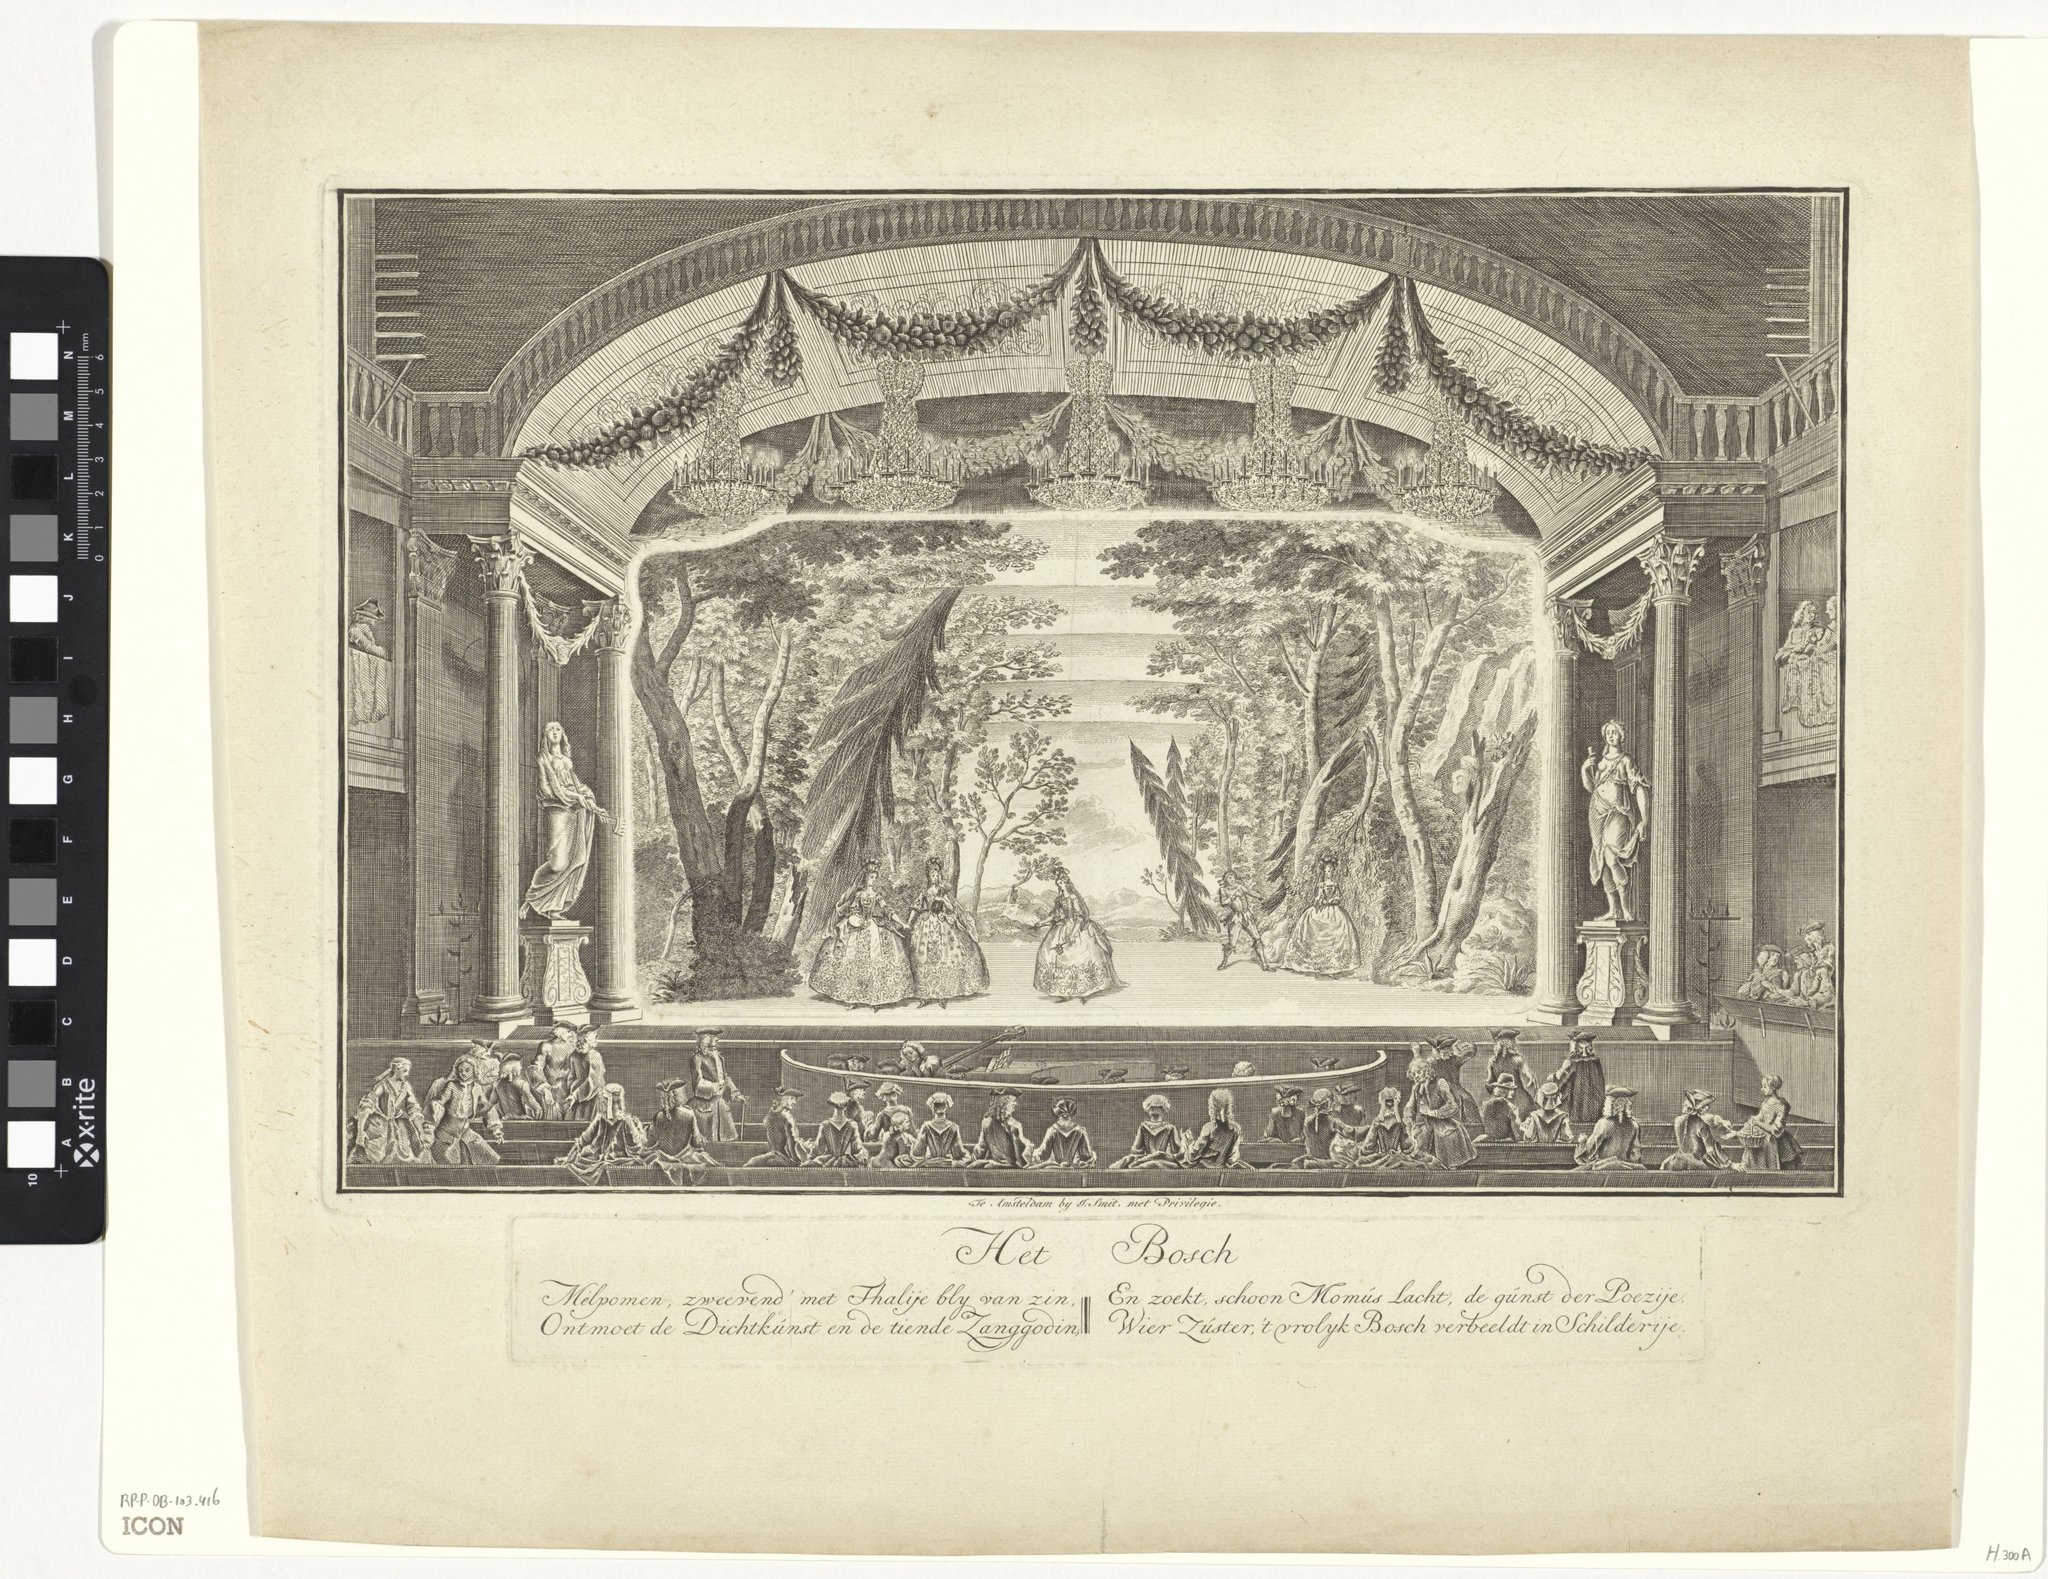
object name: print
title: Het Bosch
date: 1738-1740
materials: paper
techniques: engraving, etching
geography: amsterdam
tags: theatre, theatrical performance, stage design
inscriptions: collector's mark: Lugt 2228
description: Toneelvoorstelling in de Amsterdamse Schouwburg op de Keizersgracht met het coulissendecor Het Bosch met scène uit: Het Eeuwgetijde van den Amsteldamschen Schouwburg. Het decor gedrukt van een aparte plaat binnen een passe-partout met de zaal, zijloges, orkestbak en de façade van het toneel met zuilen, guirlandes en kroonluchters. De titel en een vierregelig vers ook gedrukt van een aparte plaat. Onderdeel van een serie van twaalf toneeldecors.